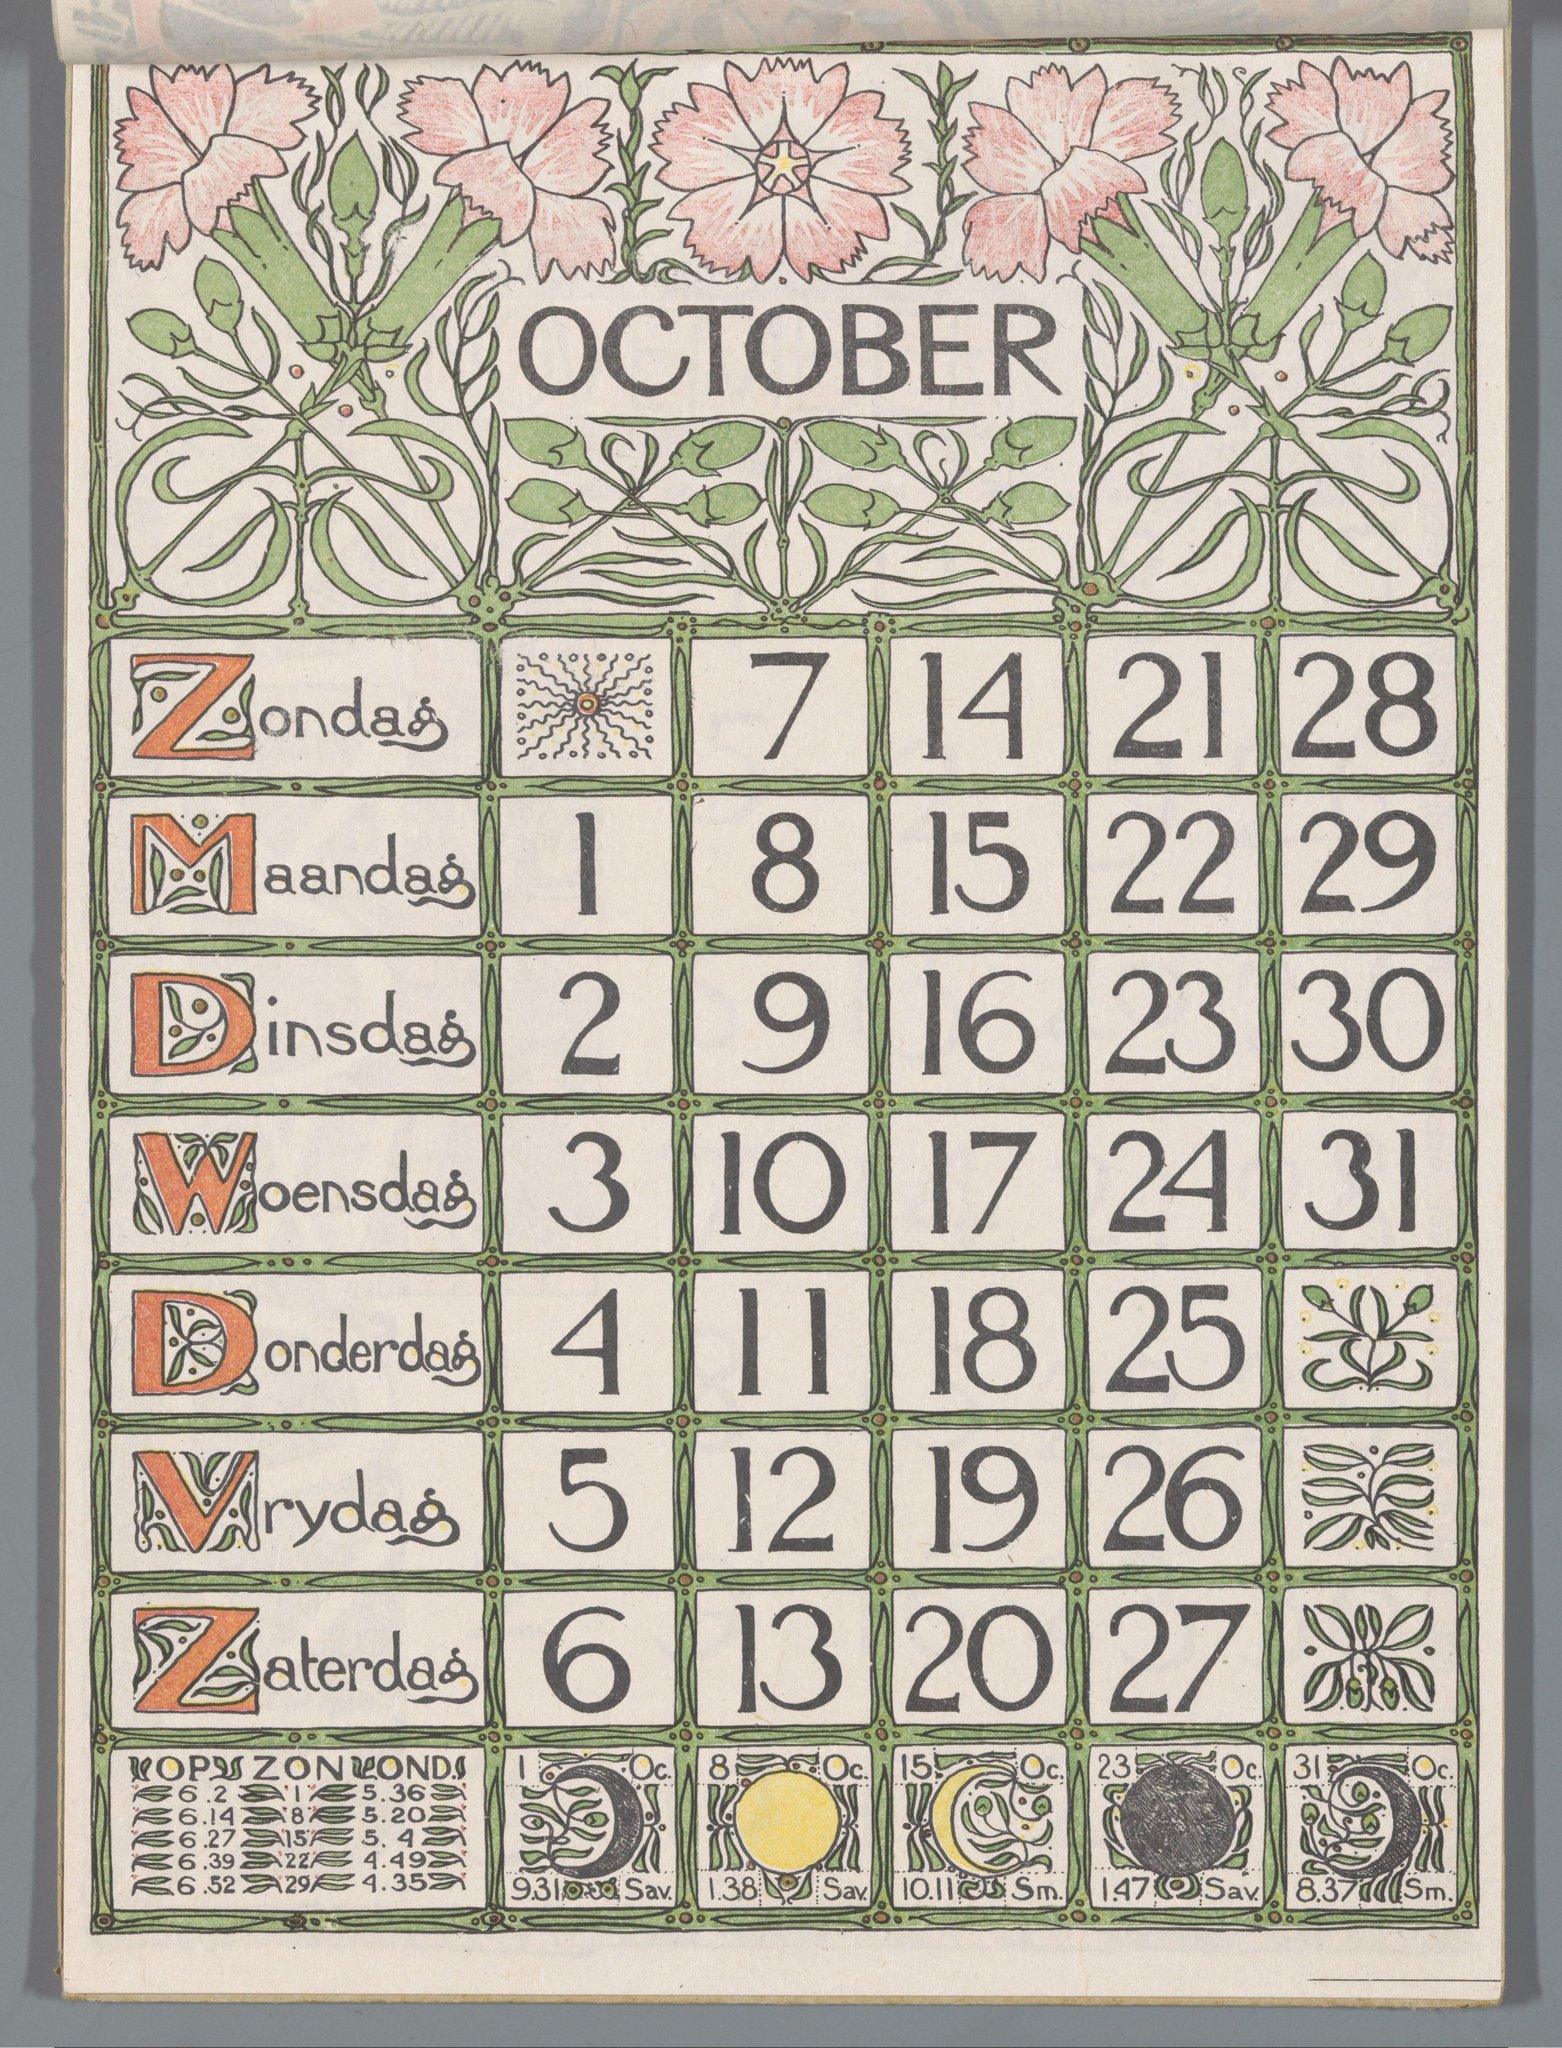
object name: print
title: Kalenderblad oktober 1900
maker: theo nieuwenhuis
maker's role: designer, draughtsman, print maker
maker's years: 1866-1951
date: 1900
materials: paper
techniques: lithograph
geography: amsterdam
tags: october ~ other concepts